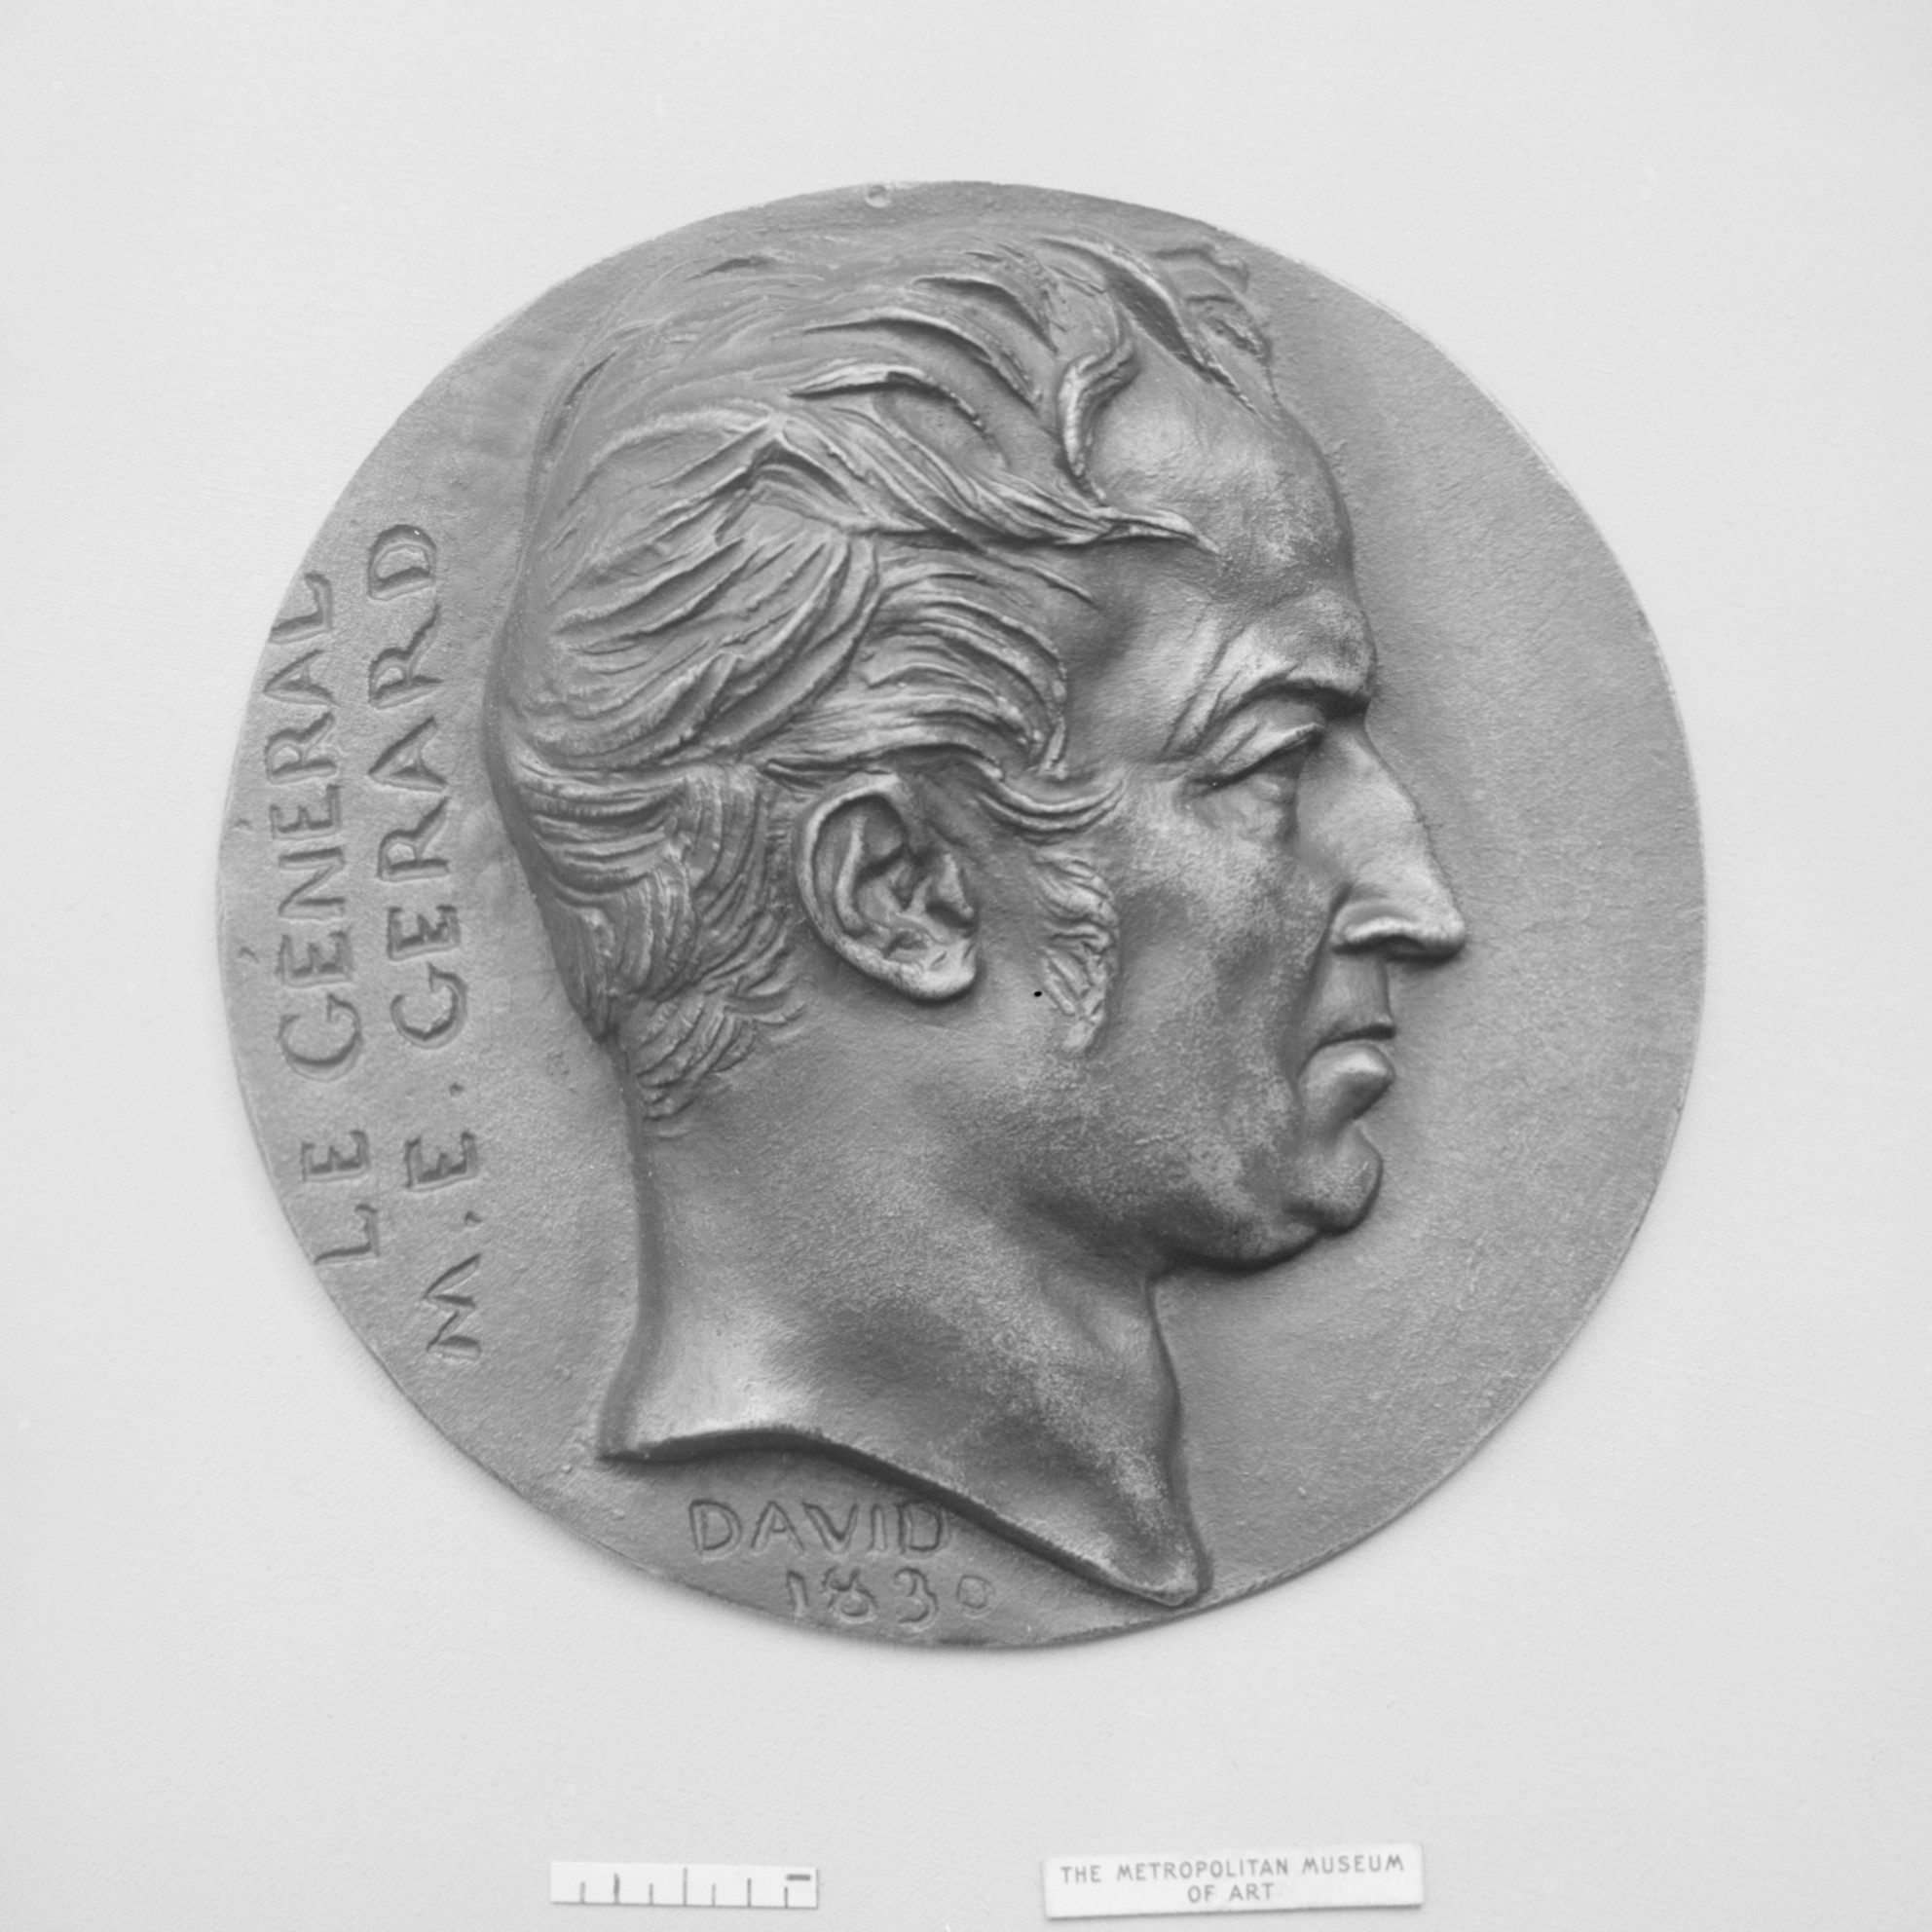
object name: medallion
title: Maurice Etienne Comte de Gerard, (1773–1852), Marshal of France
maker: pierre jean david d'angers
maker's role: artist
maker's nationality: french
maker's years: 1788-1856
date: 1830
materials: bronze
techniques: casting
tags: men,profiles